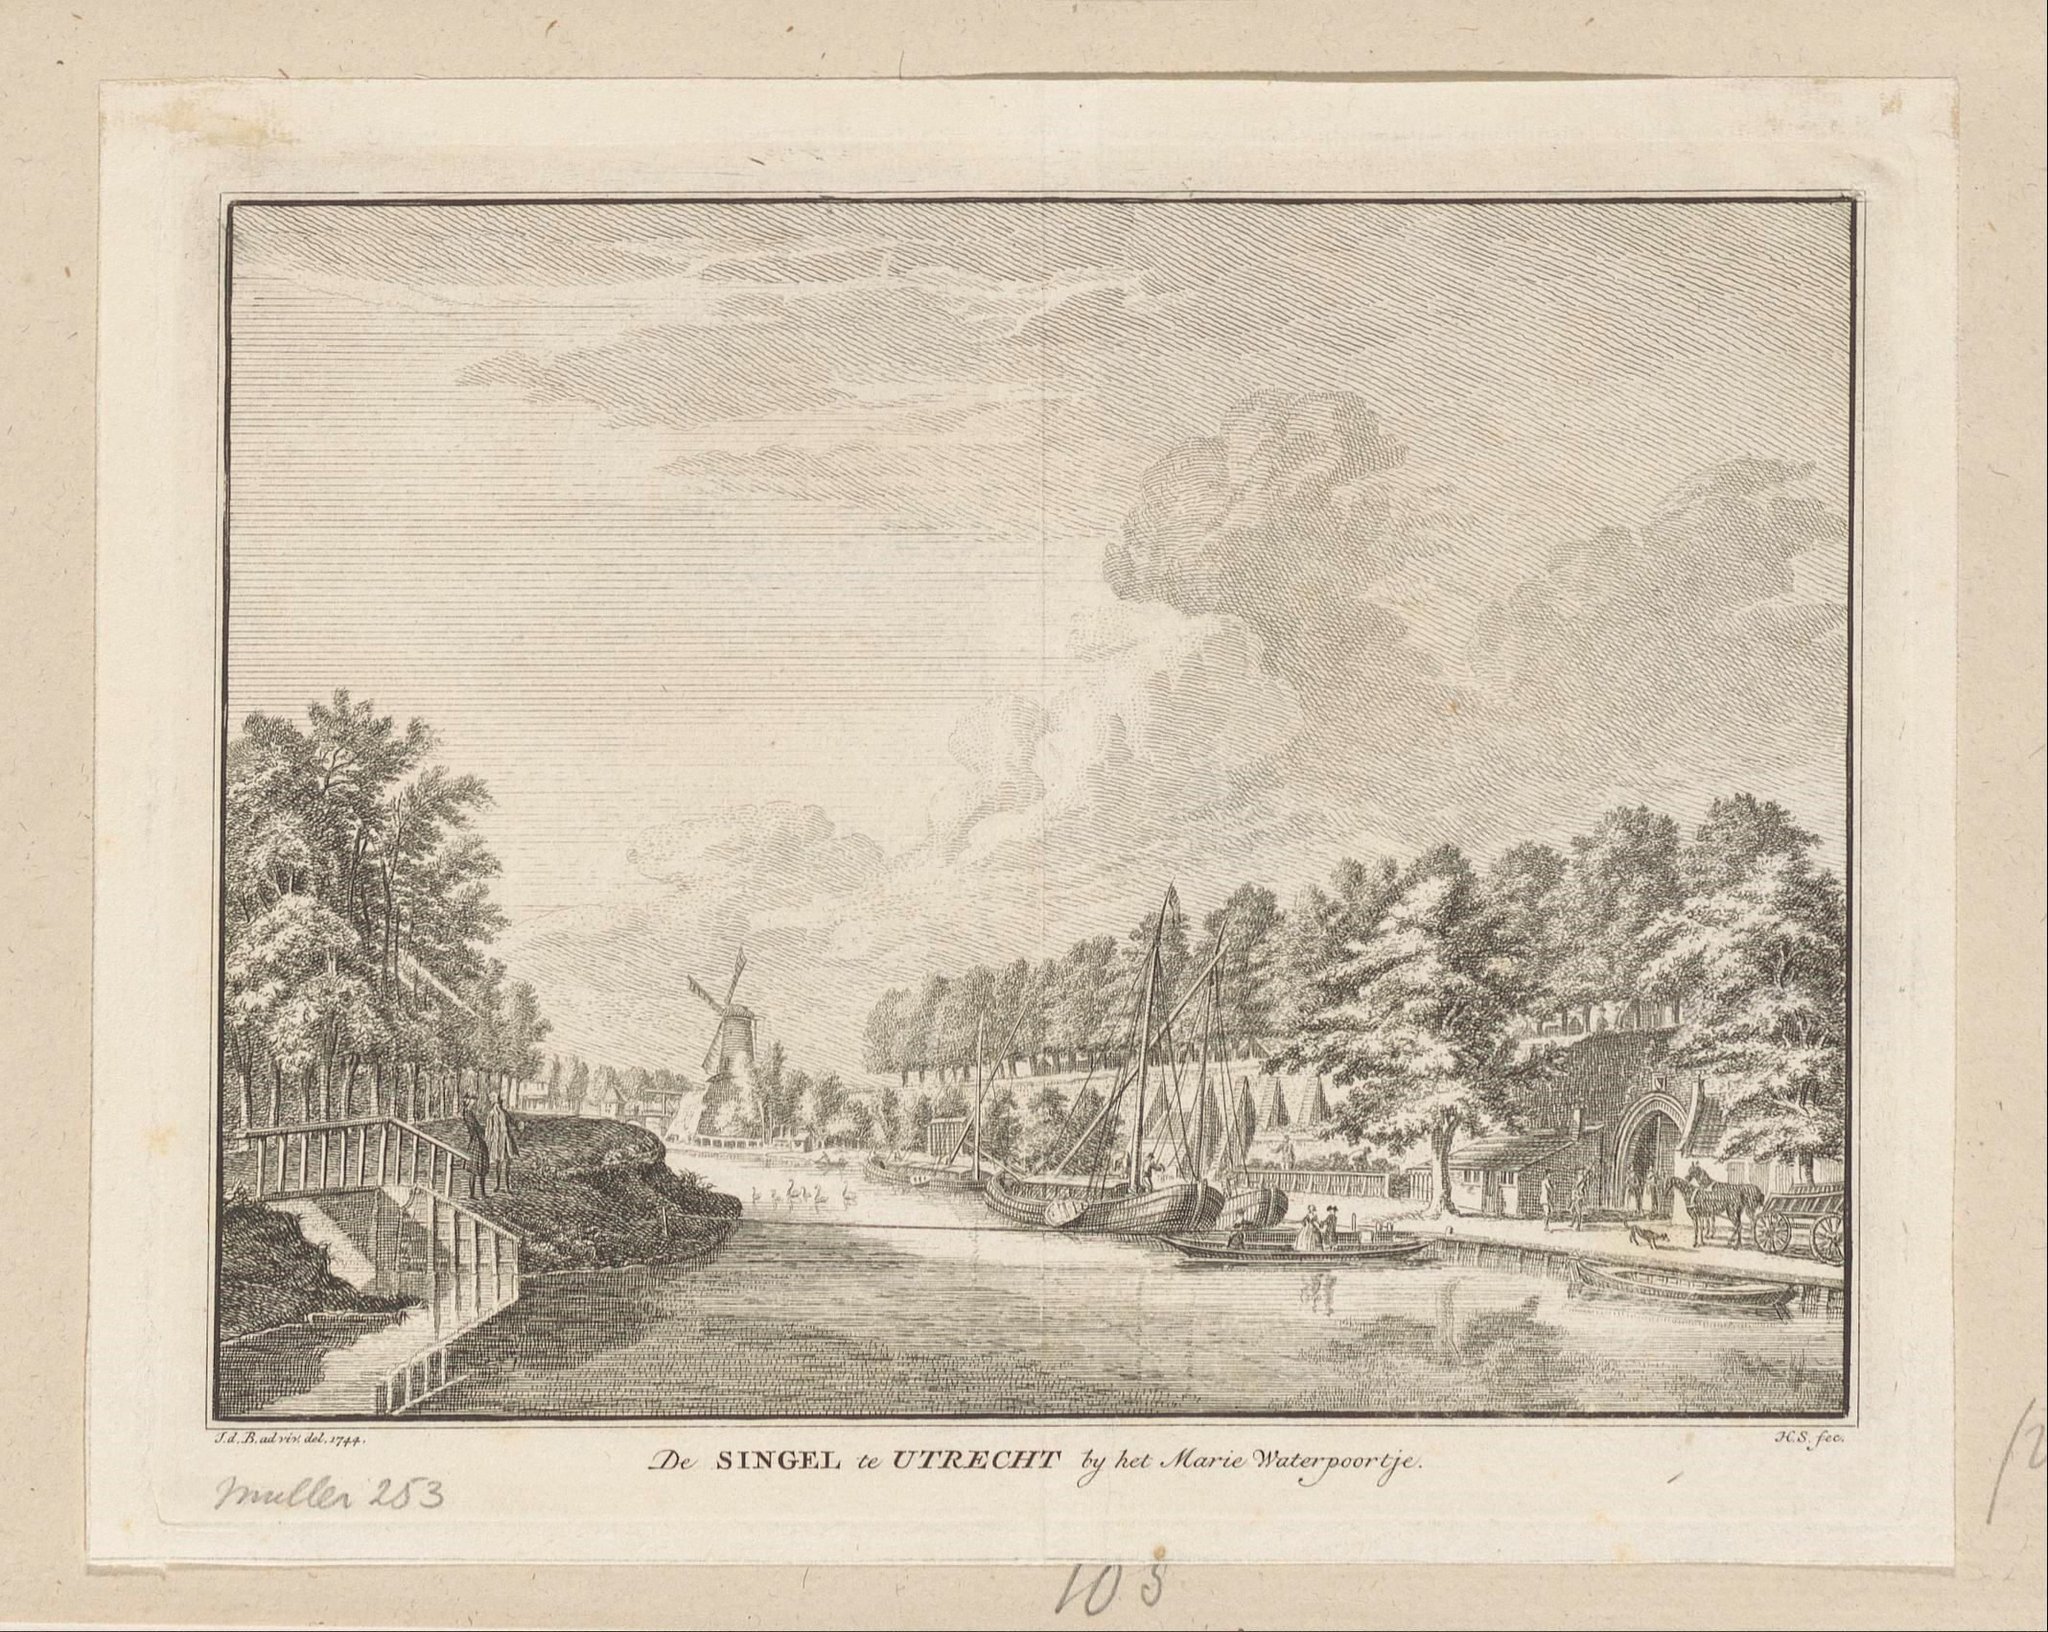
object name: print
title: De Singel te Utrecht by het Marie waterpoortje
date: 1773-1792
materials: paper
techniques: engraving, etching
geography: haarlem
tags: city-walls, city-gate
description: Prent ook gebruikt in: Het verheerlykt Nederland of kabinet van hedendaagsche gezigten van steden, dorpen (…) Behelzende honderd gezigten van der Provincie van Utrecht. Amsterdam: weduwe Isaak Tirion, 1773-1774, dl. 7, 8 of 9, niet genummerd, te vinden na ill. 144 en voor ill. 201. Of in: Nederlandsche tafereelen; of eene keurige verzameling van negen honderd fraaije gezigten van steden, dorpen, sloten, oudheden (….). 9 delen. Amsterdam: Jan de Groot, 1792, dl. 7, 8 of 9, niet genummerd, te vinden na ill. 144 en voor ill. 201. Uit welke druk het huidige exemplaar precies komt is niet na te gaan.